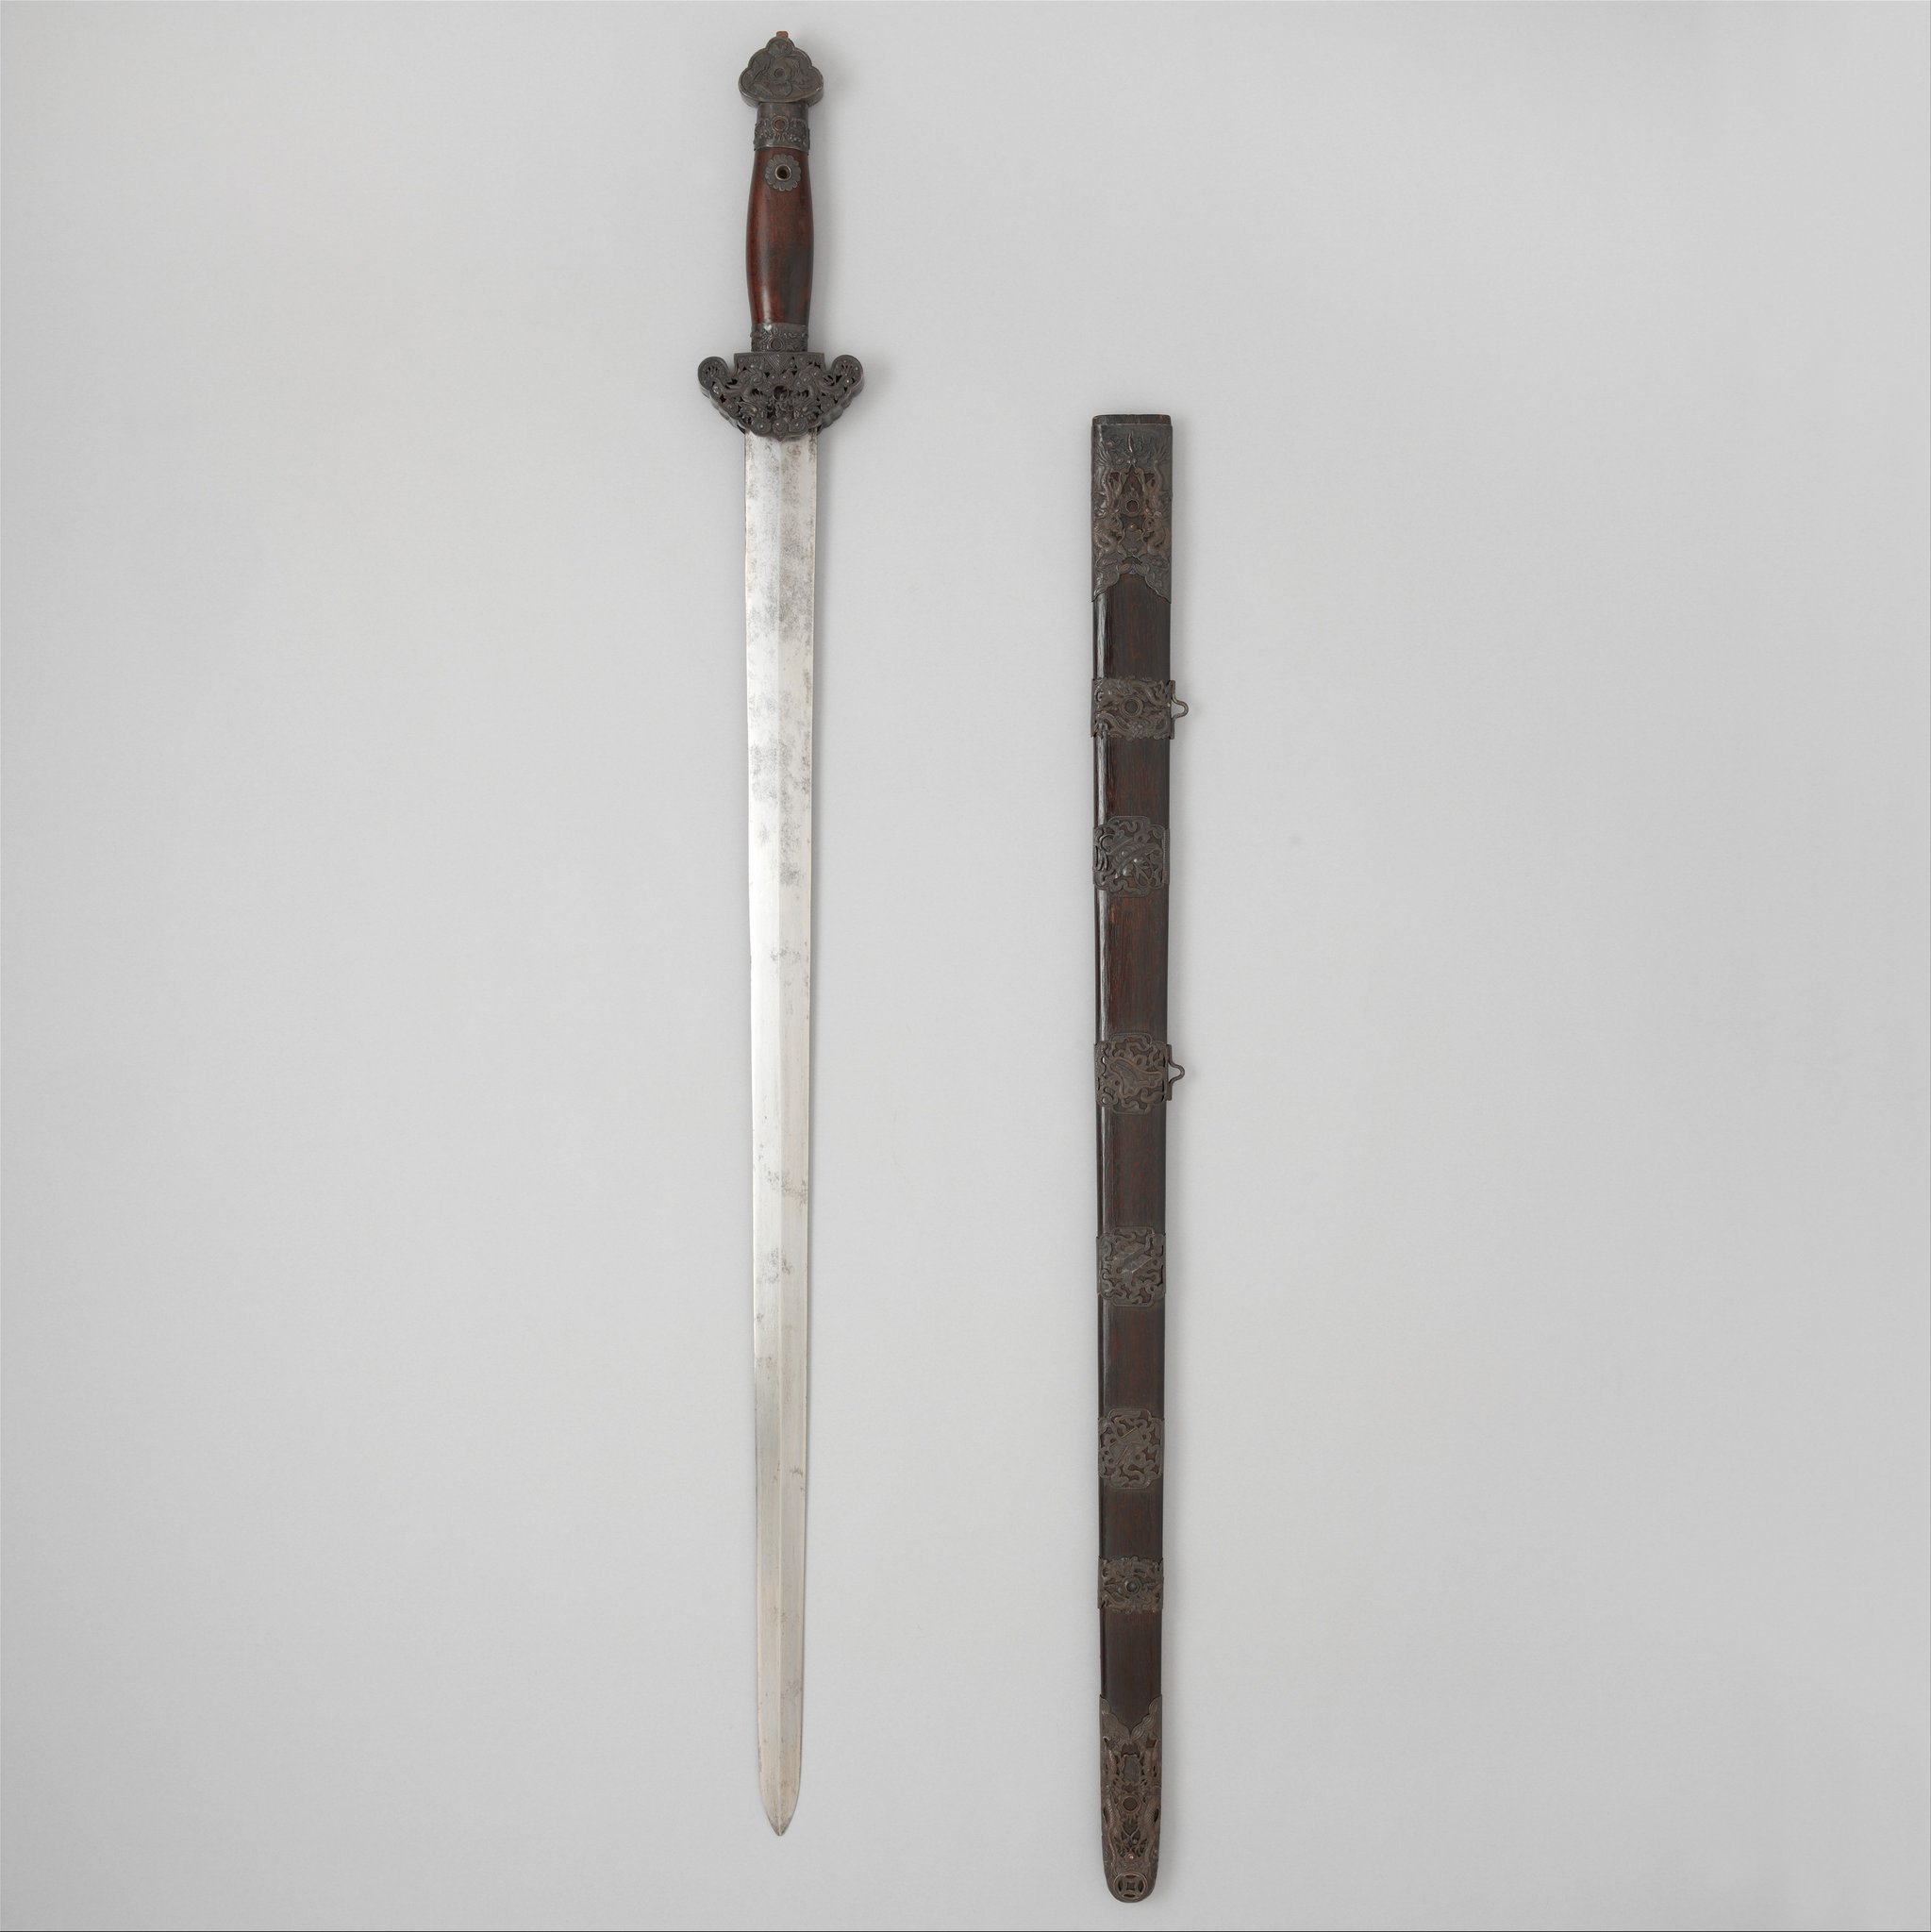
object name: sword with scabbard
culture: chinese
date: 1701-1900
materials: silver, steel, wood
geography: china